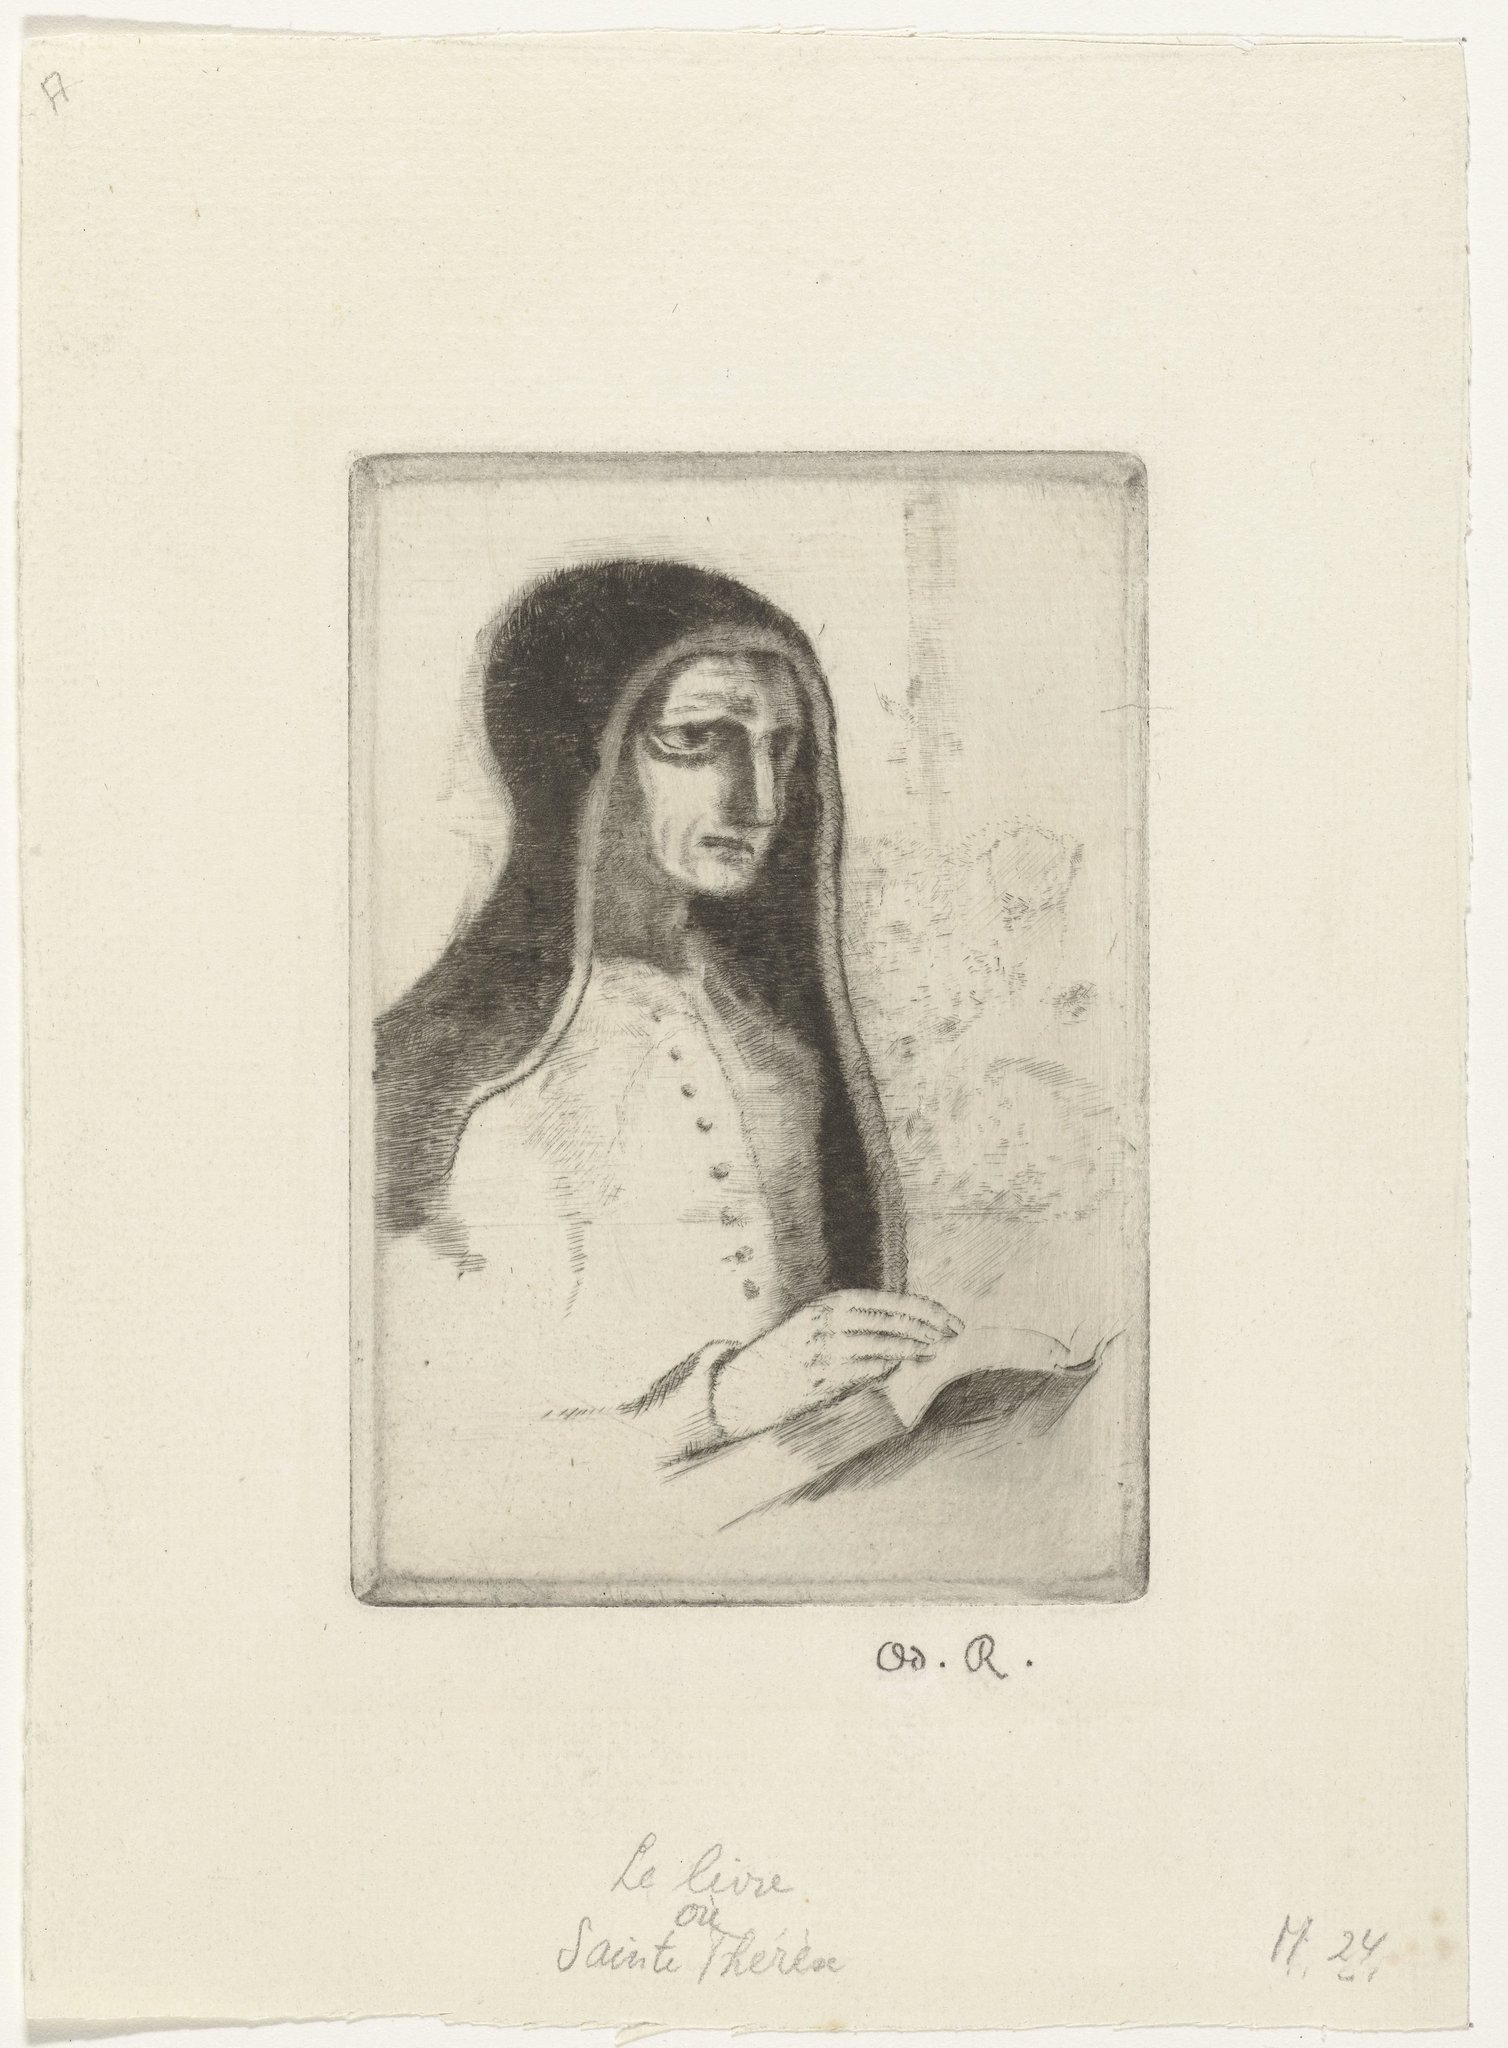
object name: print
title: Le Livre (Sainte-Thérèse)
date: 1892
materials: paper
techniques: drypoint, etching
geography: france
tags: the foundress of the reformed (discalced) carmelites, t(h)eres(i)a of avila; possible attributes: angel, arrow, dove, heart (flaming or pierced by an arrow), book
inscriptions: signature (false): ‘Od.R.’, collector's mark (): Lugt 2760, collector's mark (): Lugt 2228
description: Deze prent is geëtst op de plaat die eerder door Redon gebruikt is voor "Enigma". K.Botke